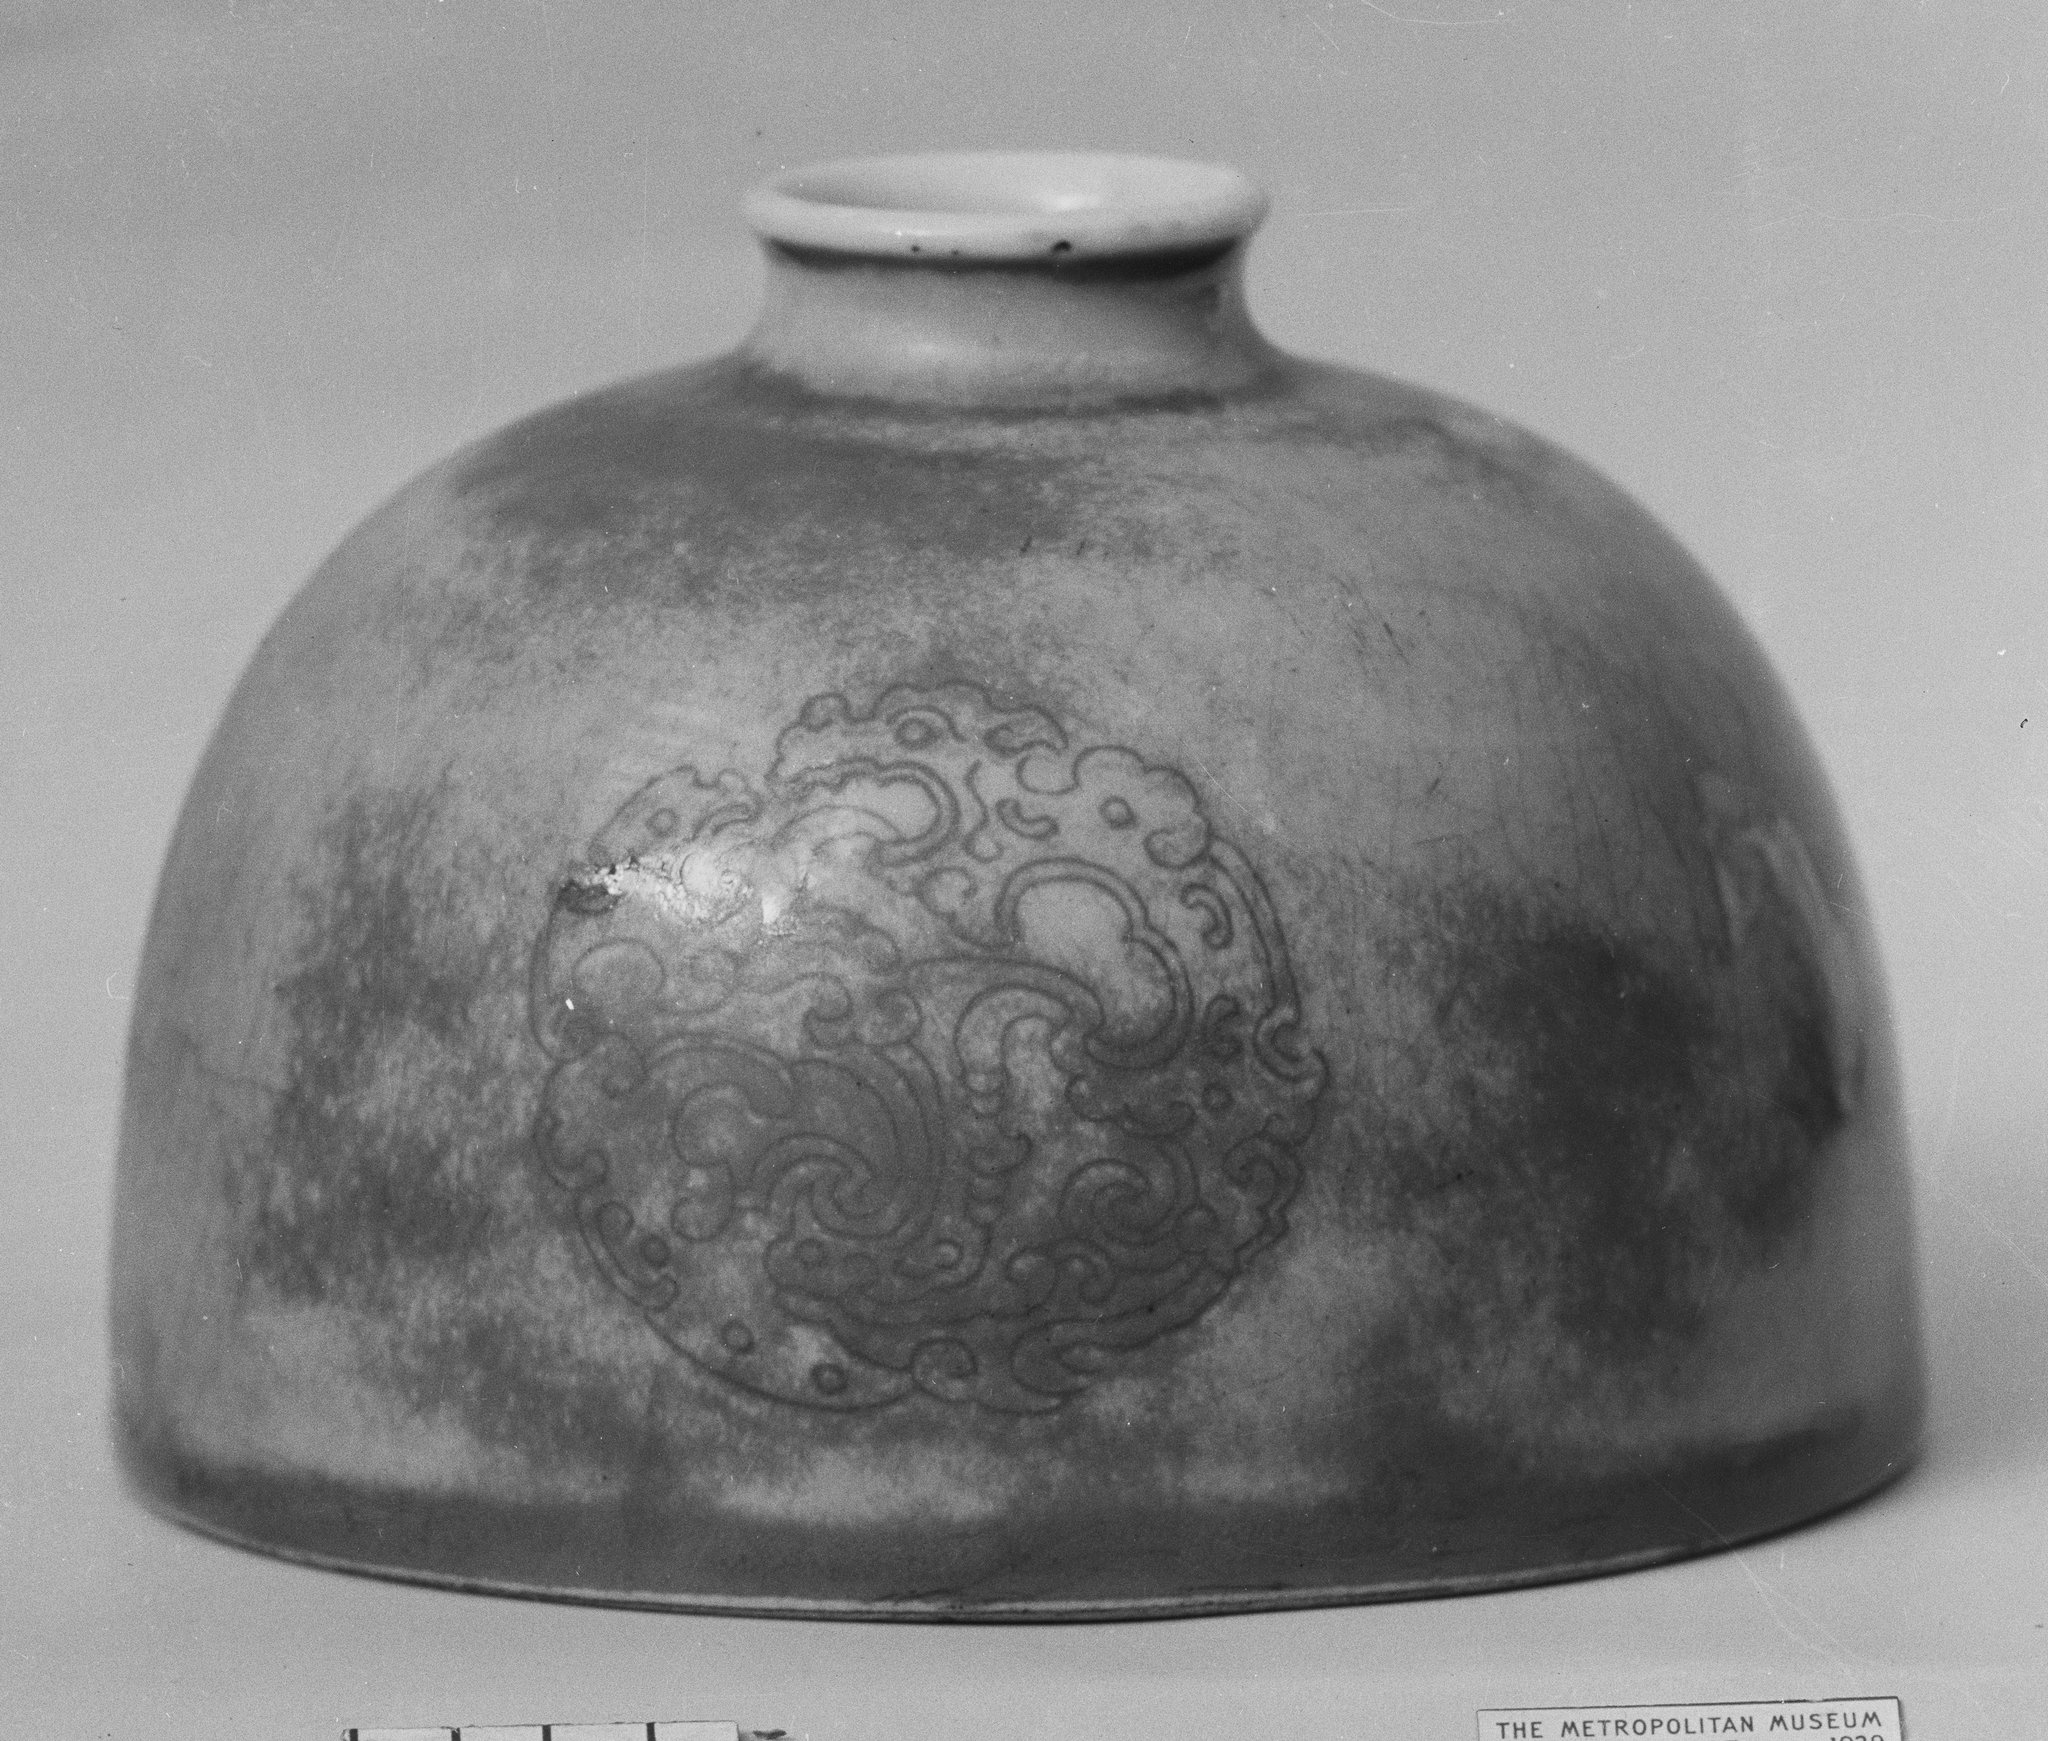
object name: water coupe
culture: chinese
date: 1662-1722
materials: glaze, porcelain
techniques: incising